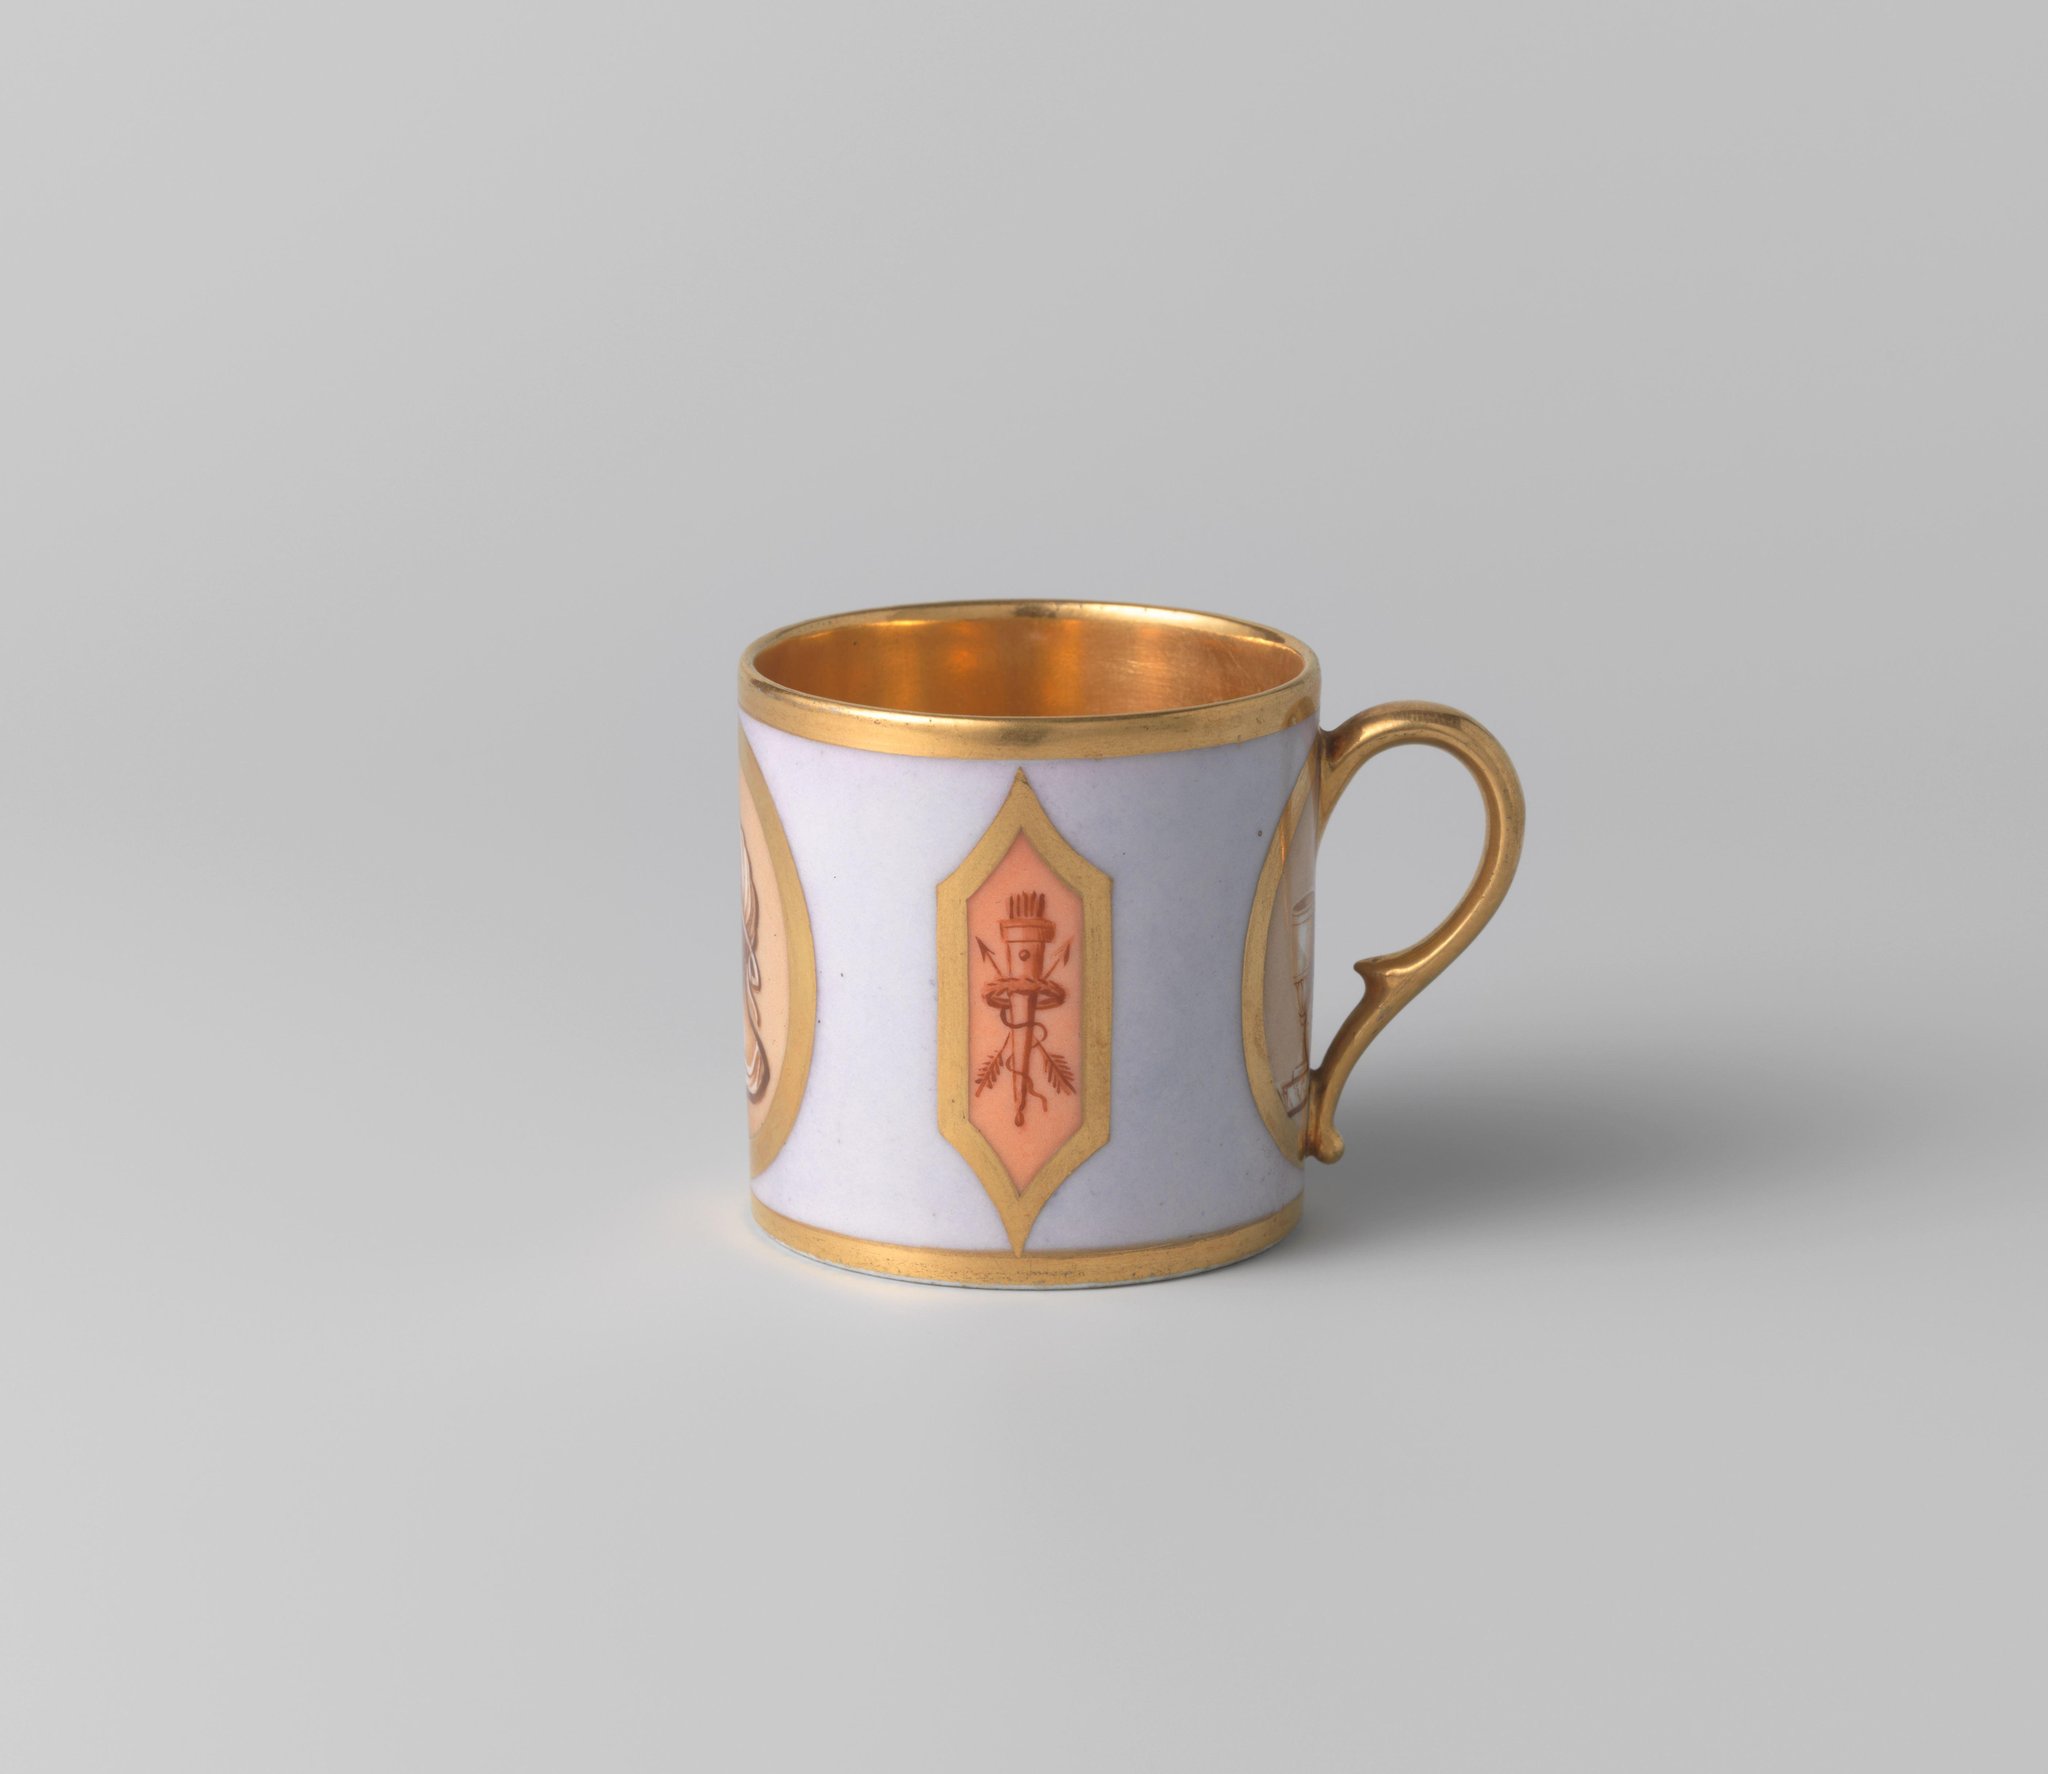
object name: cup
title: Cup with a portait and objects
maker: Anonymous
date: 1800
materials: glaze, gold, paint, porcelain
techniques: firing, forming, gilding, relief, turning, vitrification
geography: france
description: Kop van porselein met een cilindrische wand en C-vormig oor, beschilderd op het glazuur in rood, paars, bruin en goud. De buitenwand is bedekt met paars met op de voorzijde een gouden medaillon met daarin een portret van een vrouw en profil. Aan weerszijden hiervan een smal vak met o.a. een pijlenkoker. Om het oor een twee medaillon met een kan en een kelk. Het oor en de binnenwand zijn bedekt met goud, uitgespaard op de bodem een rozet.